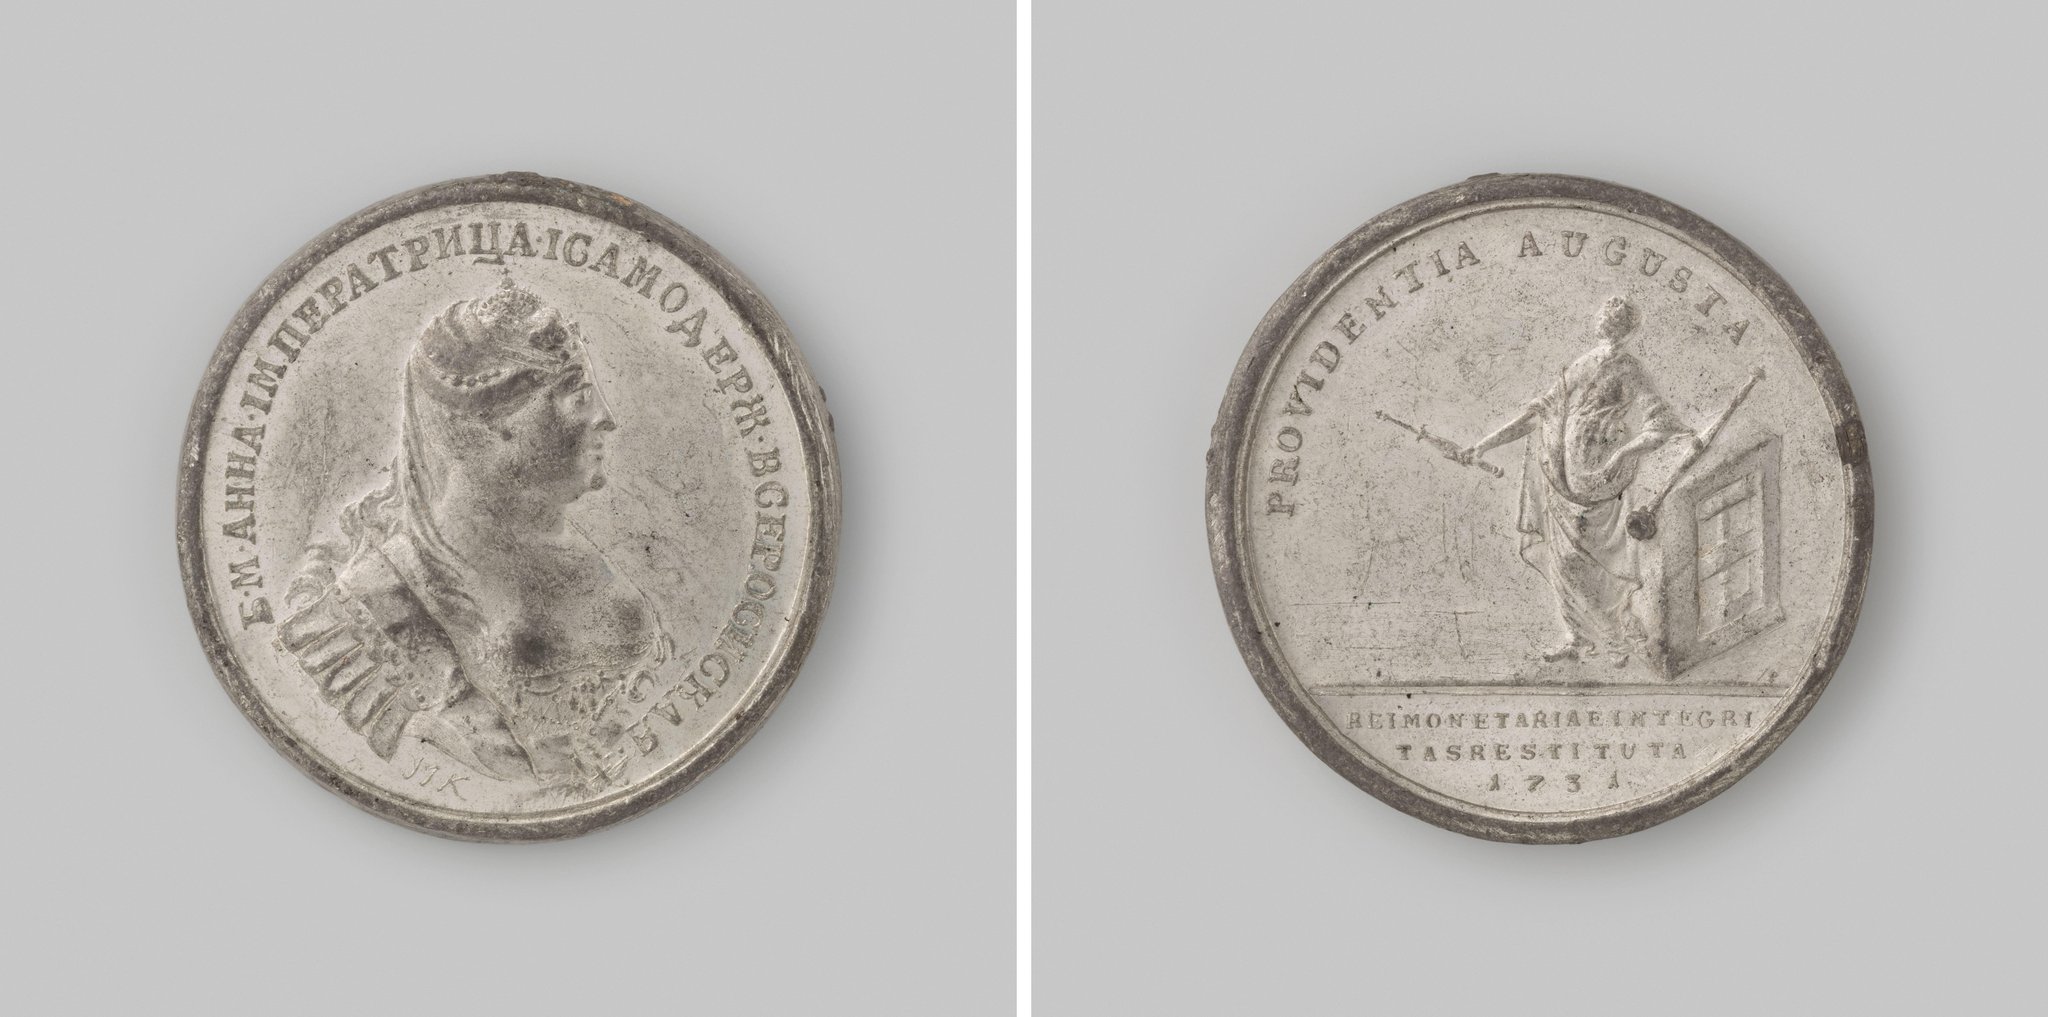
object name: history medal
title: Herstel van de munt onder Tsarina Anna van Rusland 1731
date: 1731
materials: tin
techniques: striking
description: Tinnen penning, op de voorzijde het borstbeeld van Tsarina Anna naar rechts met omschrift, op de keerzijde Anna met scepter naast een schroefpers, met omschrift en afsnedetekst.